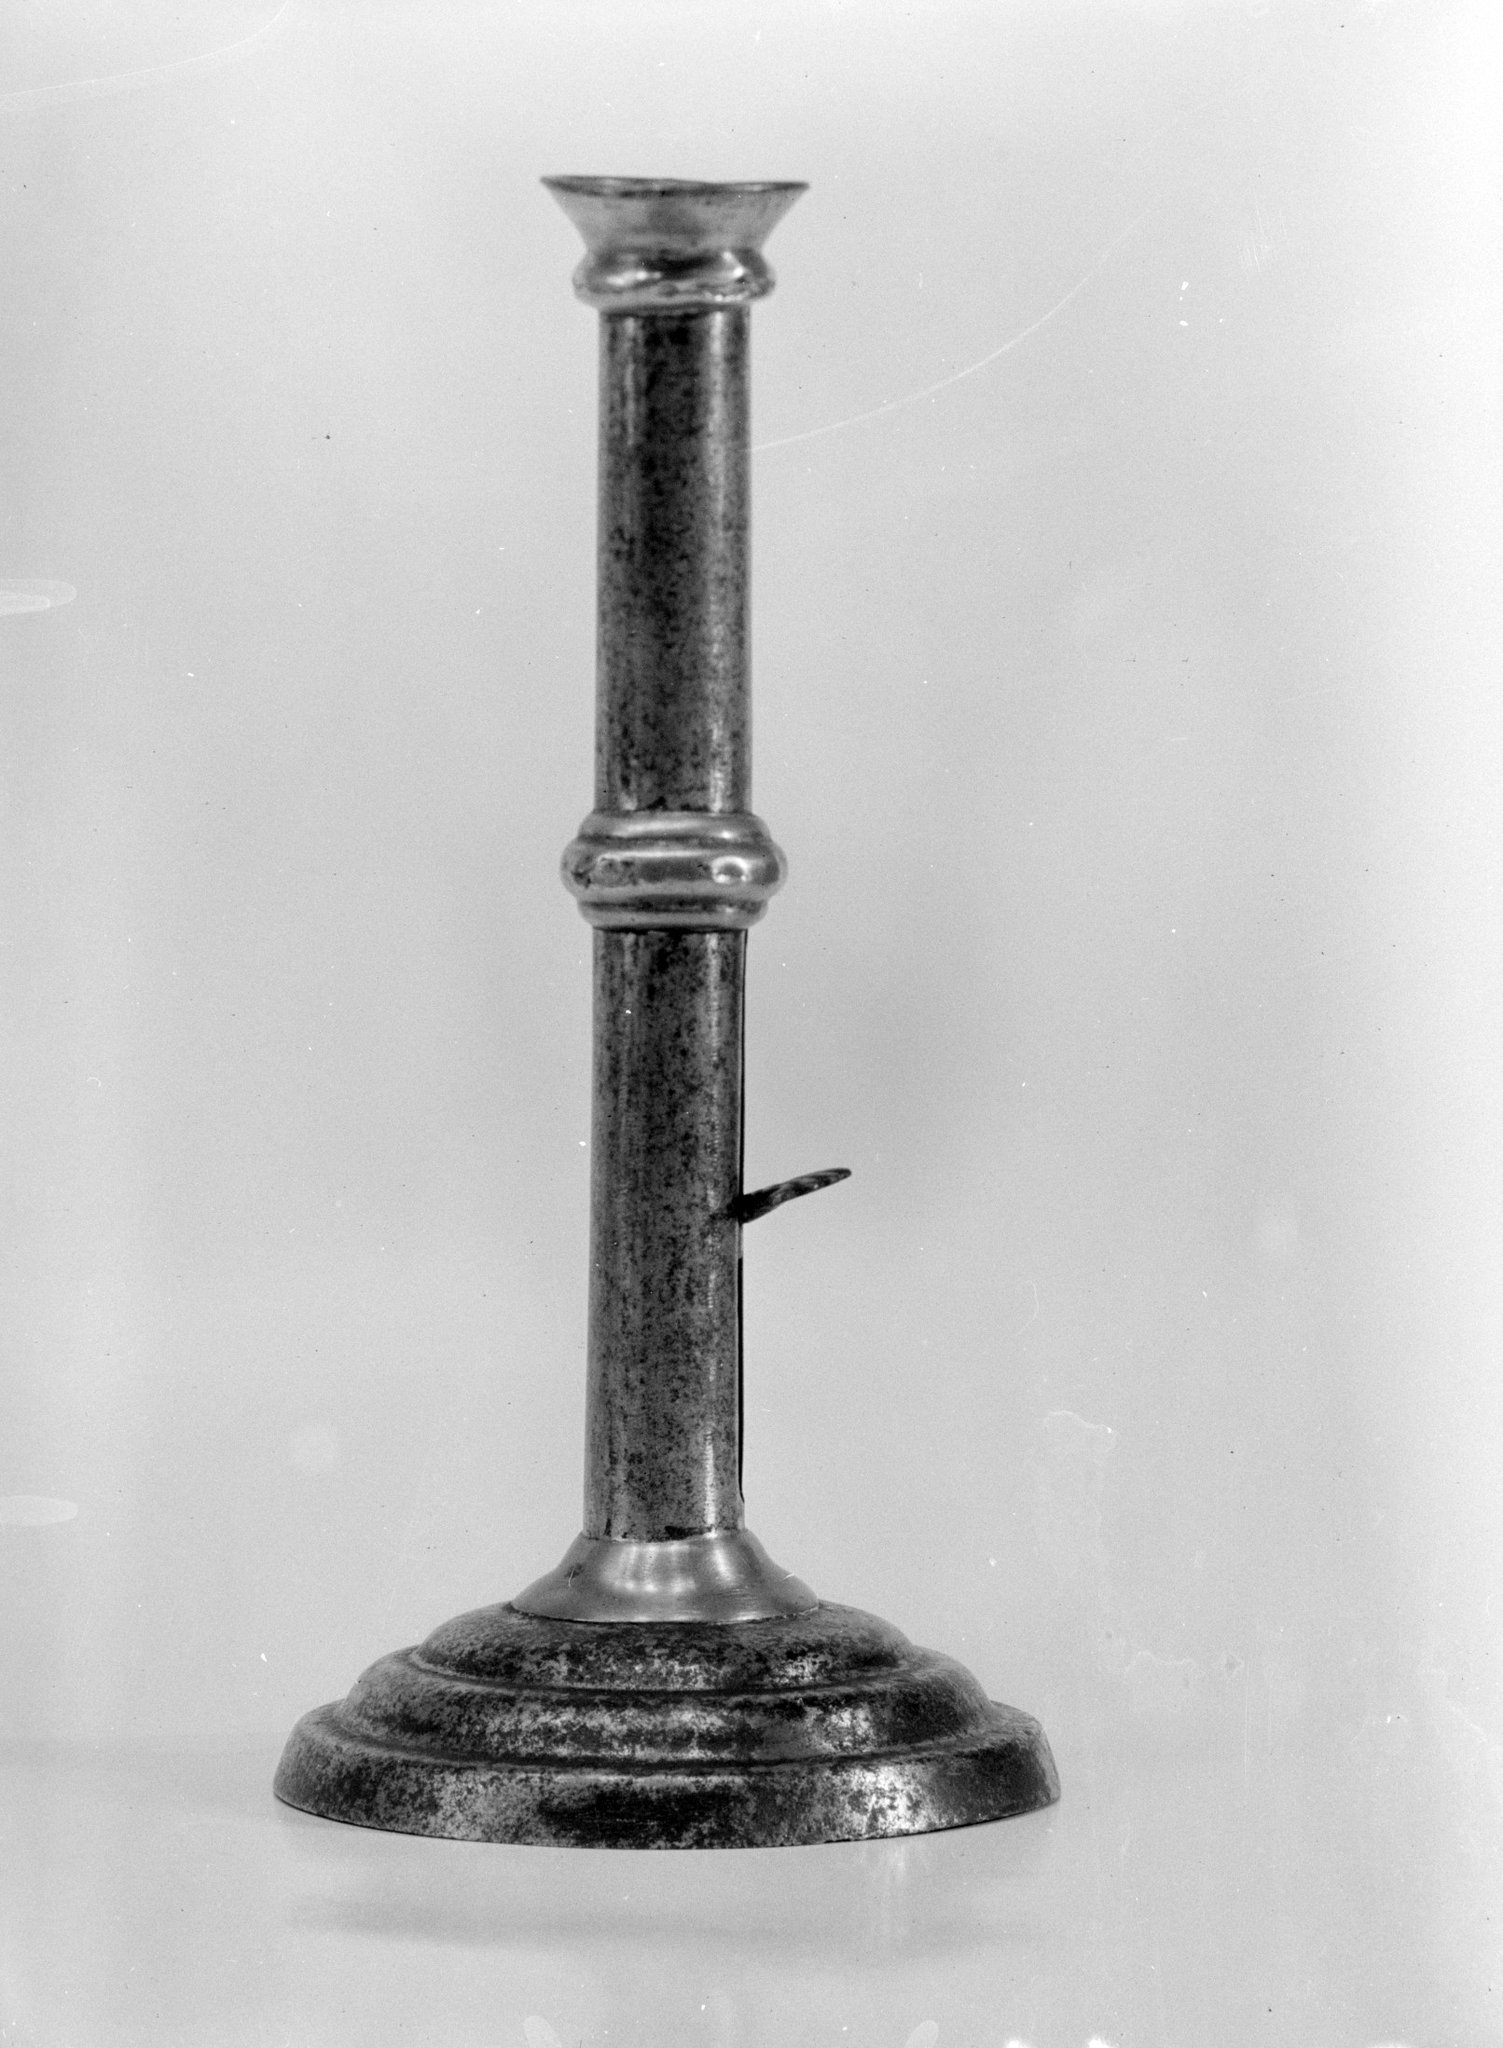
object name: candlestick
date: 1700-1800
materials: brass, steel